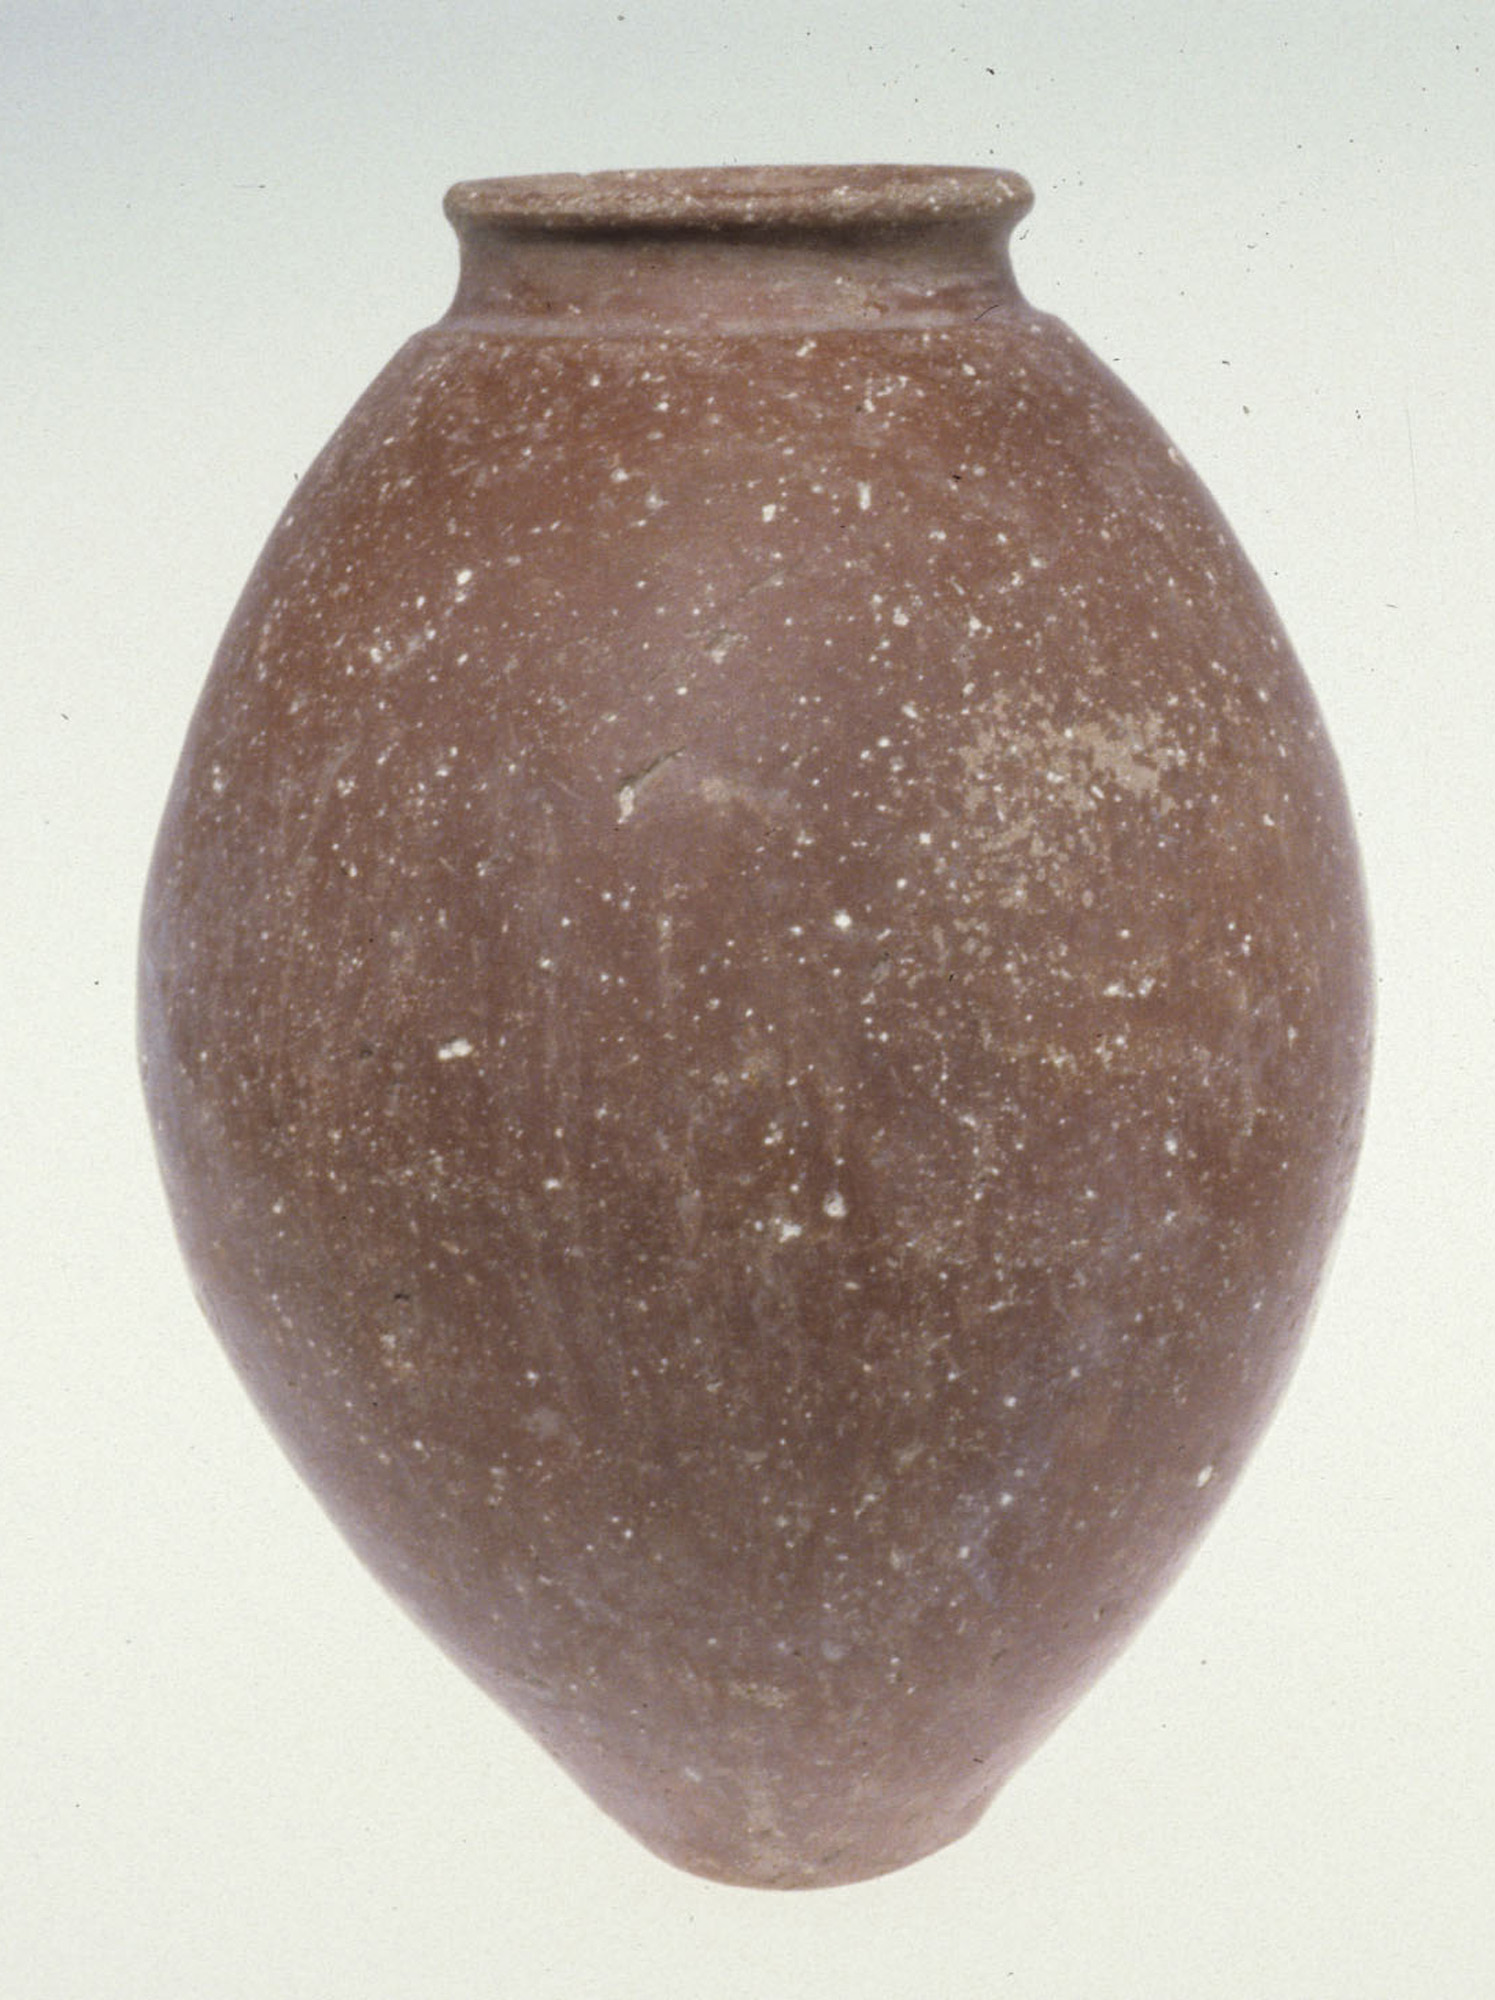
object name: jar, red polished ware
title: Red polished ware jar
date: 3500-3300 BCE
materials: pottery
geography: egypt